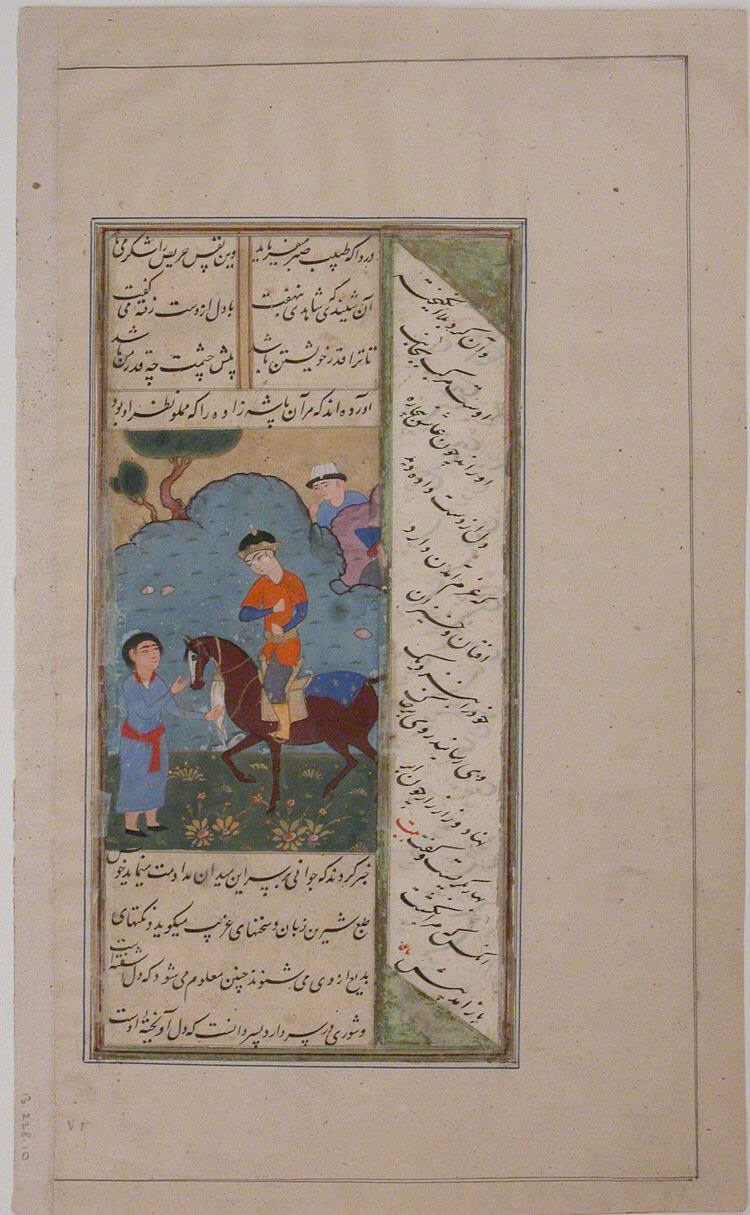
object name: folio from an illustrated manuscript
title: "A Youth, who has Fallen in Love with a Princess, Dies at her Feet when she Speaks", Folio from a Kulliyat (Complete Works) of Sa'di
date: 1801-1900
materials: gold, ink, paper, watercolor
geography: india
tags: men,horses